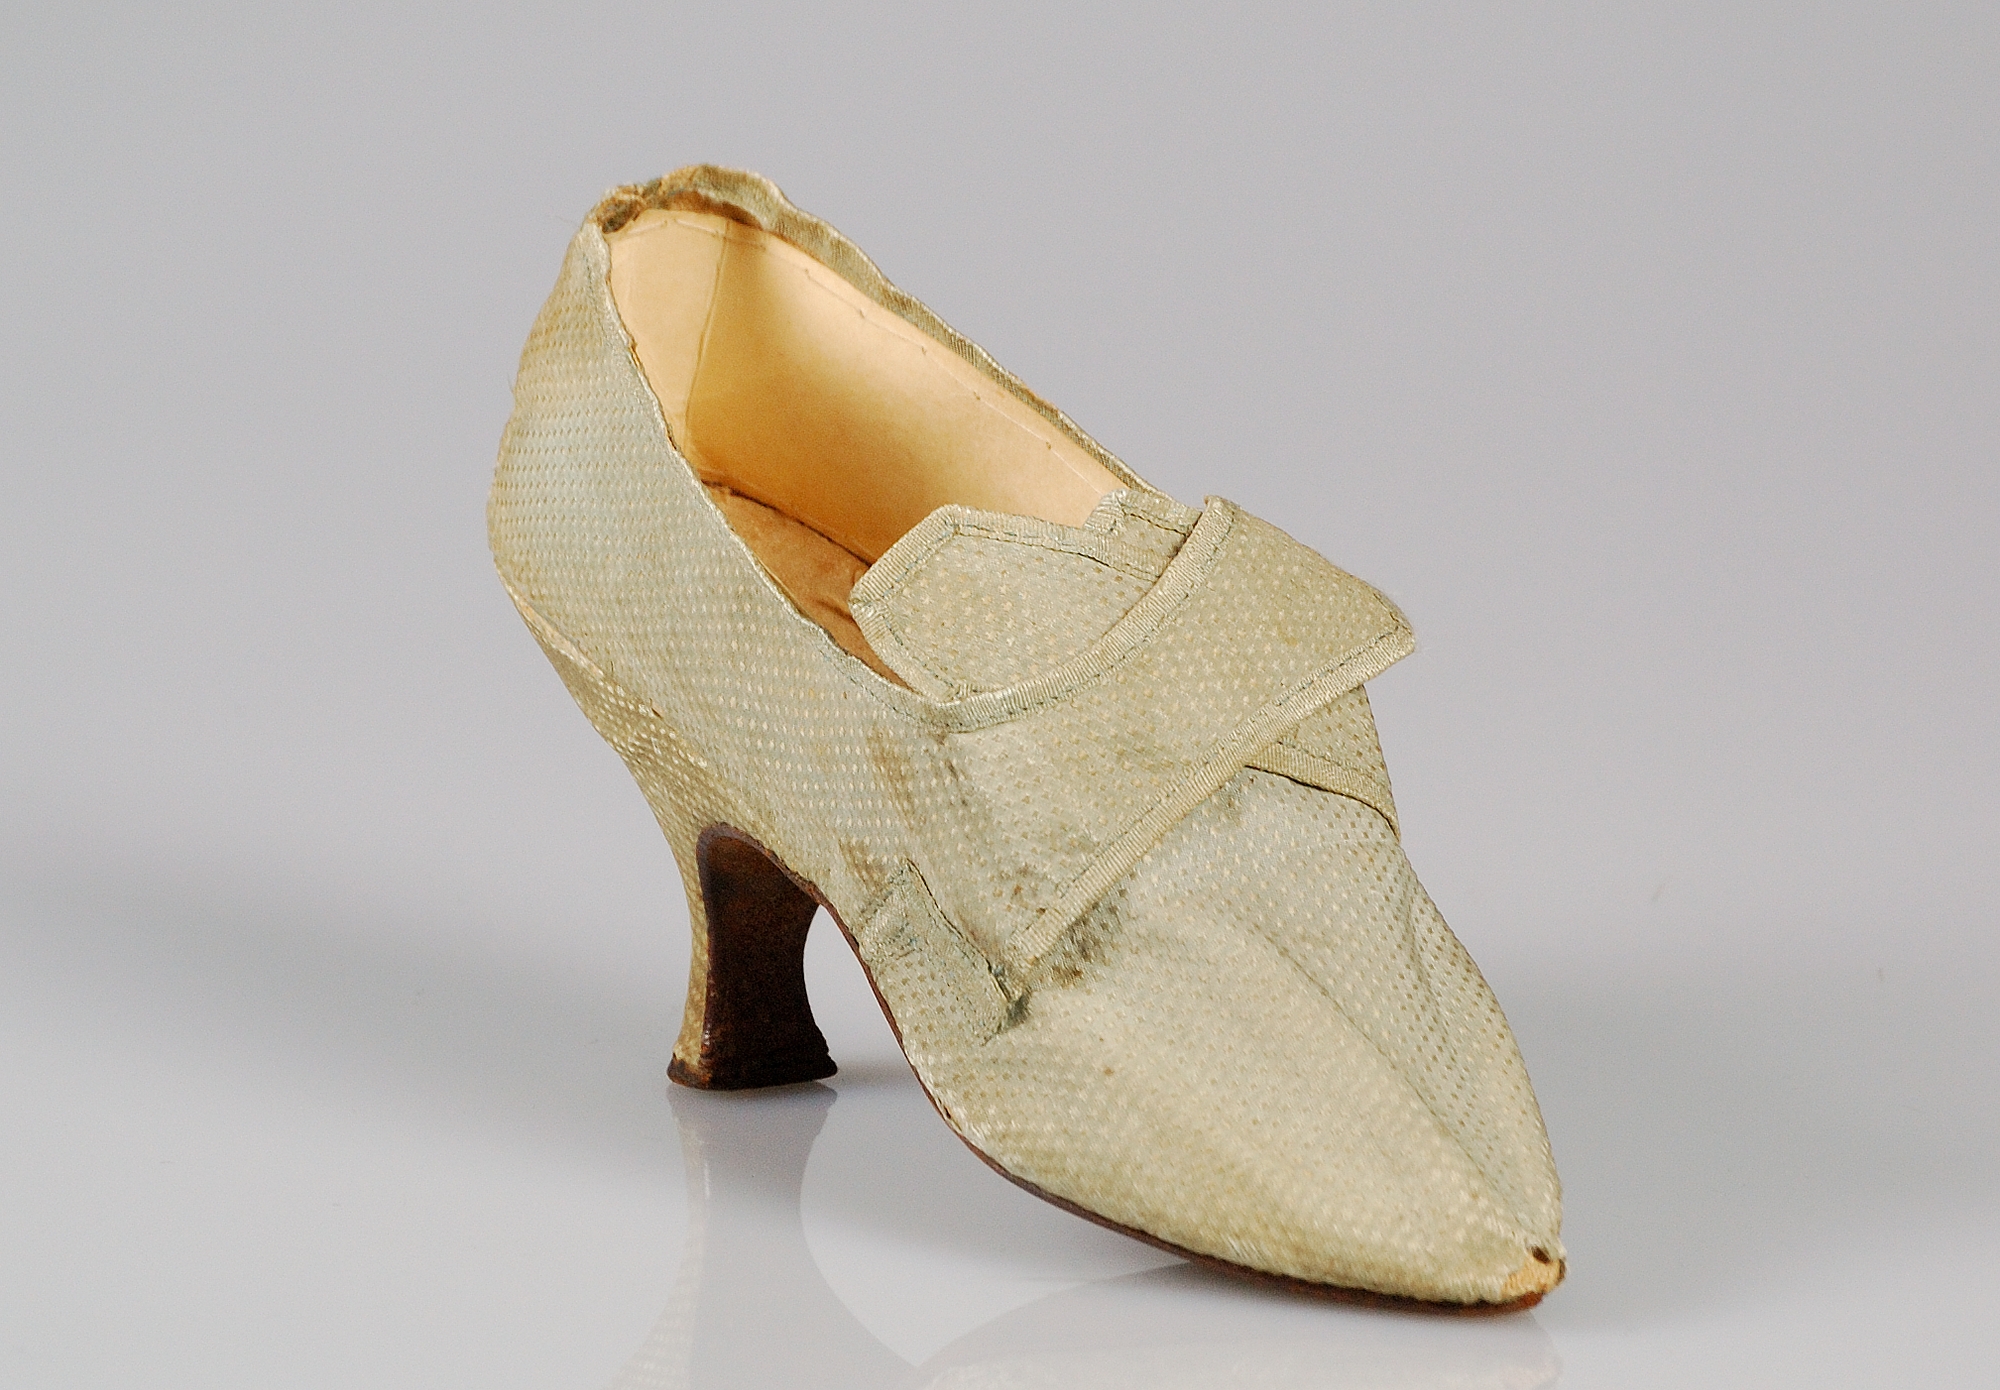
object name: shoe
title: Shoes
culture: american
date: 1780-1795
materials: silk